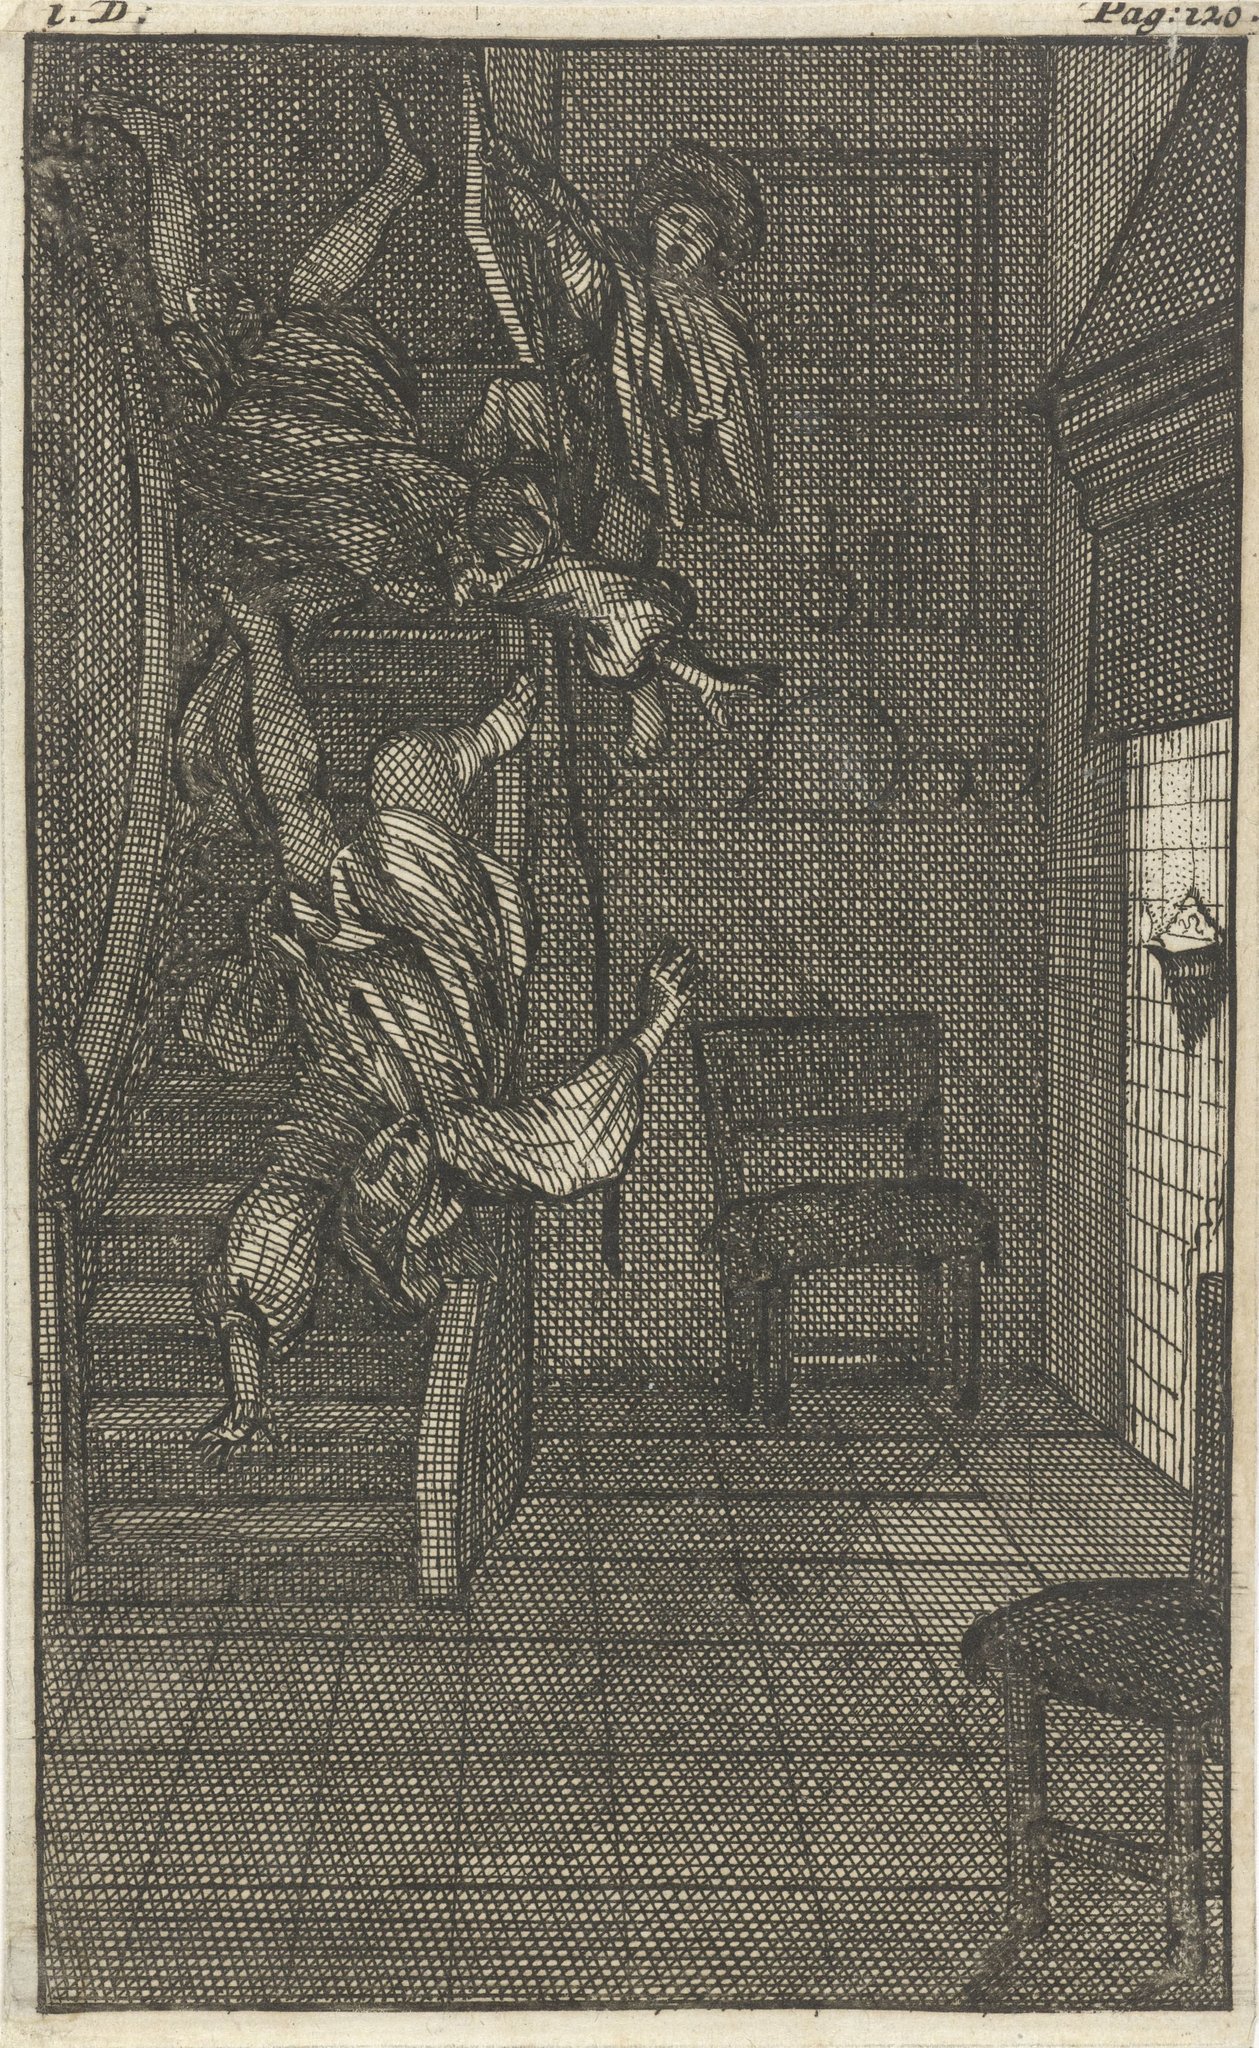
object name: book illustration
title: Mirandors meesteres, de markiezin, met haar minnaar ontdekt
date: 1695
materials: paper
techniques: etching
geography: amsterdam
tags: staircase, falling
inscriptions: collector's mark: Lugt 2228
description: Illustratie uit: Heinsius, Nicolaas jr. Den vermakelyken avanturier, ofte De wispelturige, en niet min wonderlyke levens-loop van Mirandor, 2 delen. Amsterdam: Pieter van Amsterdam, 1695, dl. I.